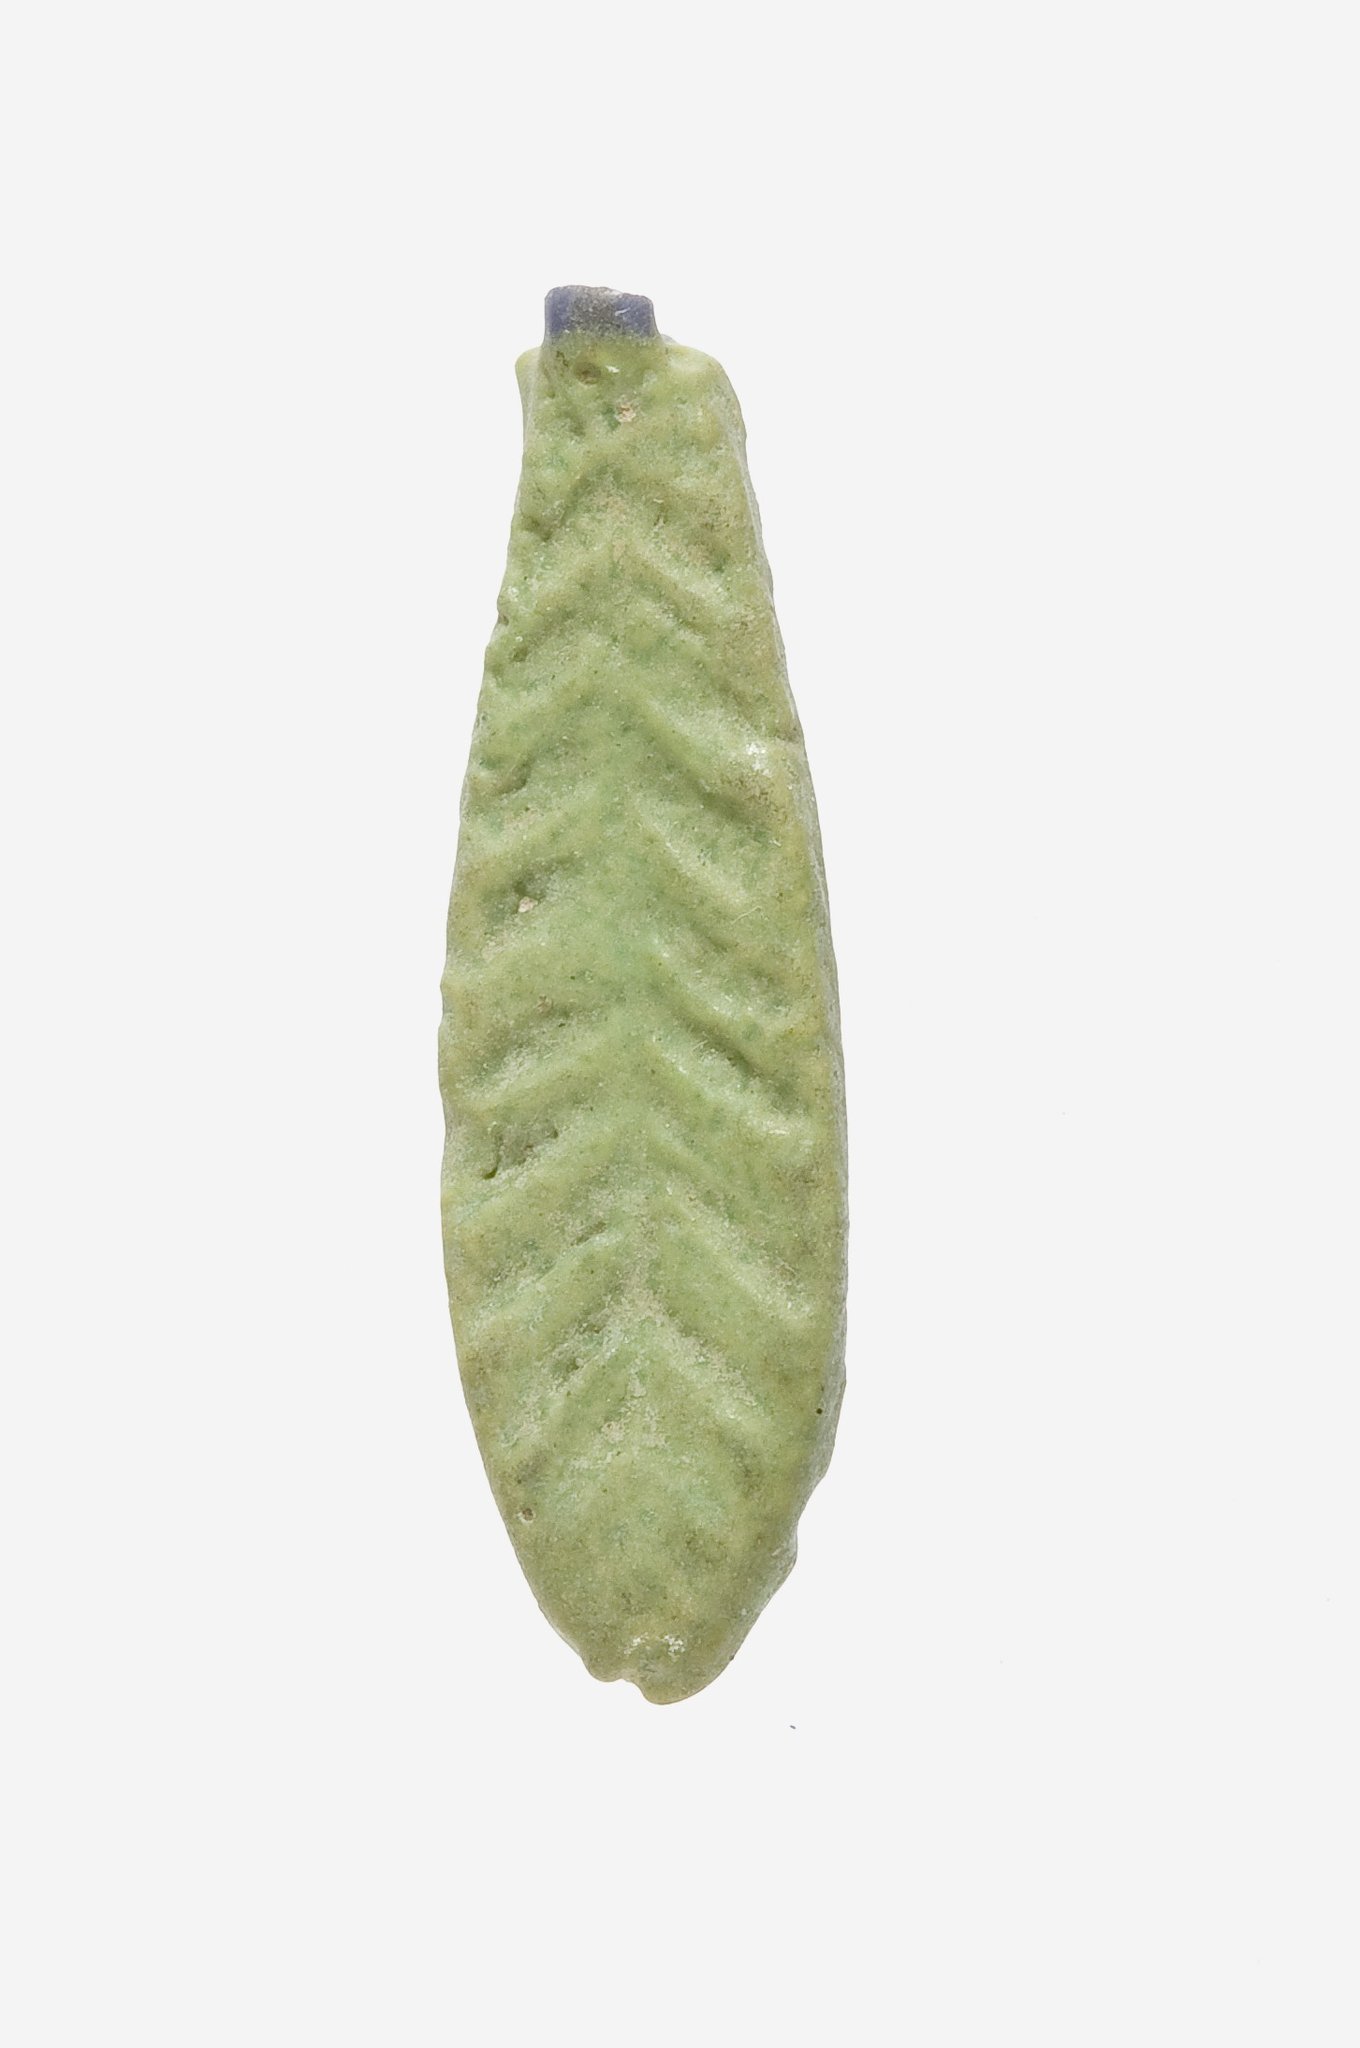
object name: pendant, leaf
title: Leaf Pendant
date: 1390-1352 BCE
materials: faience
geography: egypt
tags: leaves